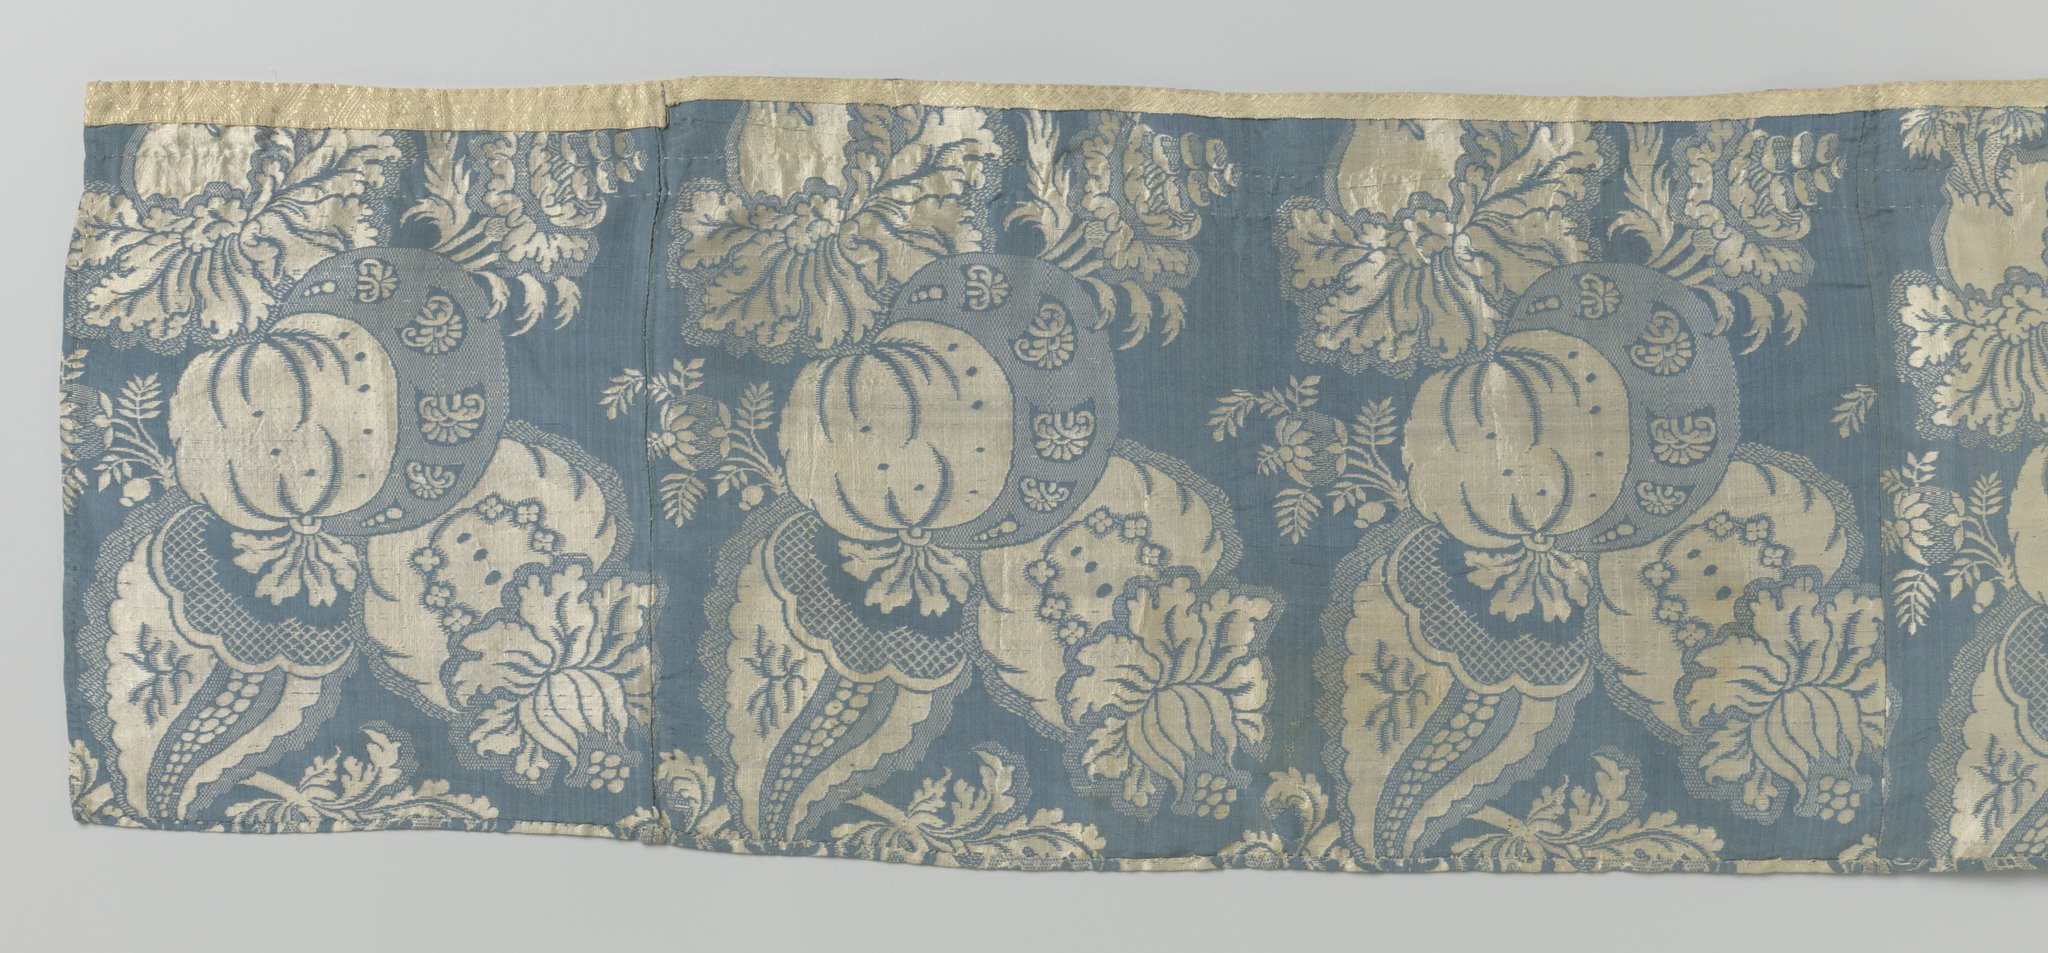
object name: silk textile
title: Fragment van een zijdeweefsel met een patroon van een fors boeket en granaatappel in wit op blauw, een zogenaamd mozaïekdecor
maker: Anonymous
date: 1700-1725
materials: silk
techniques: weave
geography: france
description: Fragment van een zijdeweefsel met een lopend patroon van zeer grote bloemen en een vrucht. Een boeket is om een hangende granaatappel gerangschikt. Linksonder een peervormig blad met gelobde contouren en mozaïekranden en nerf. Rechtsonder een losse bloem, linksboven een papaver met grote zaadbol als hart en rechtsboven drie uitschuivende bloemen. Onder het blad een gebogen bloemtak op een schuin afgesneden verbrede voet. Opmerking: fragment bekleding(?) van een "wangenstoel".